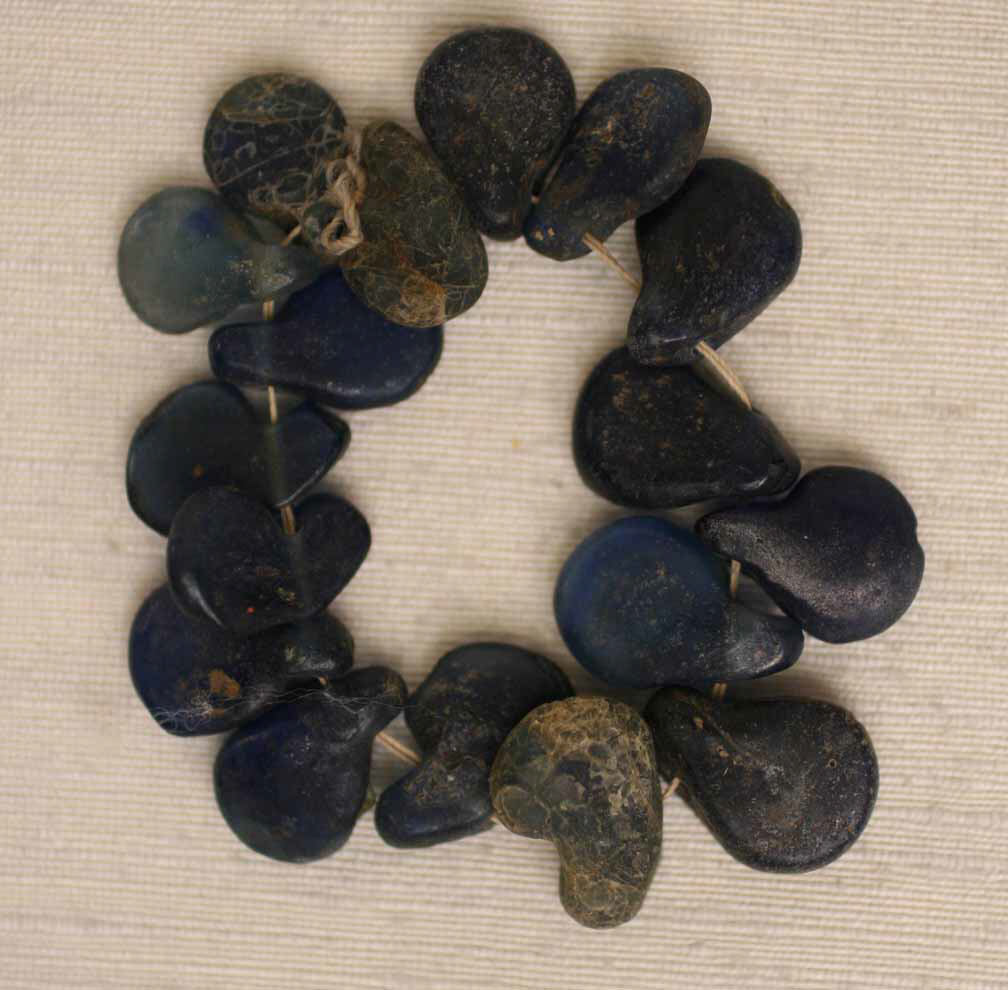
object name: pendant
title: Pendants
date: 201-1200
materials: glass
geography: egypt